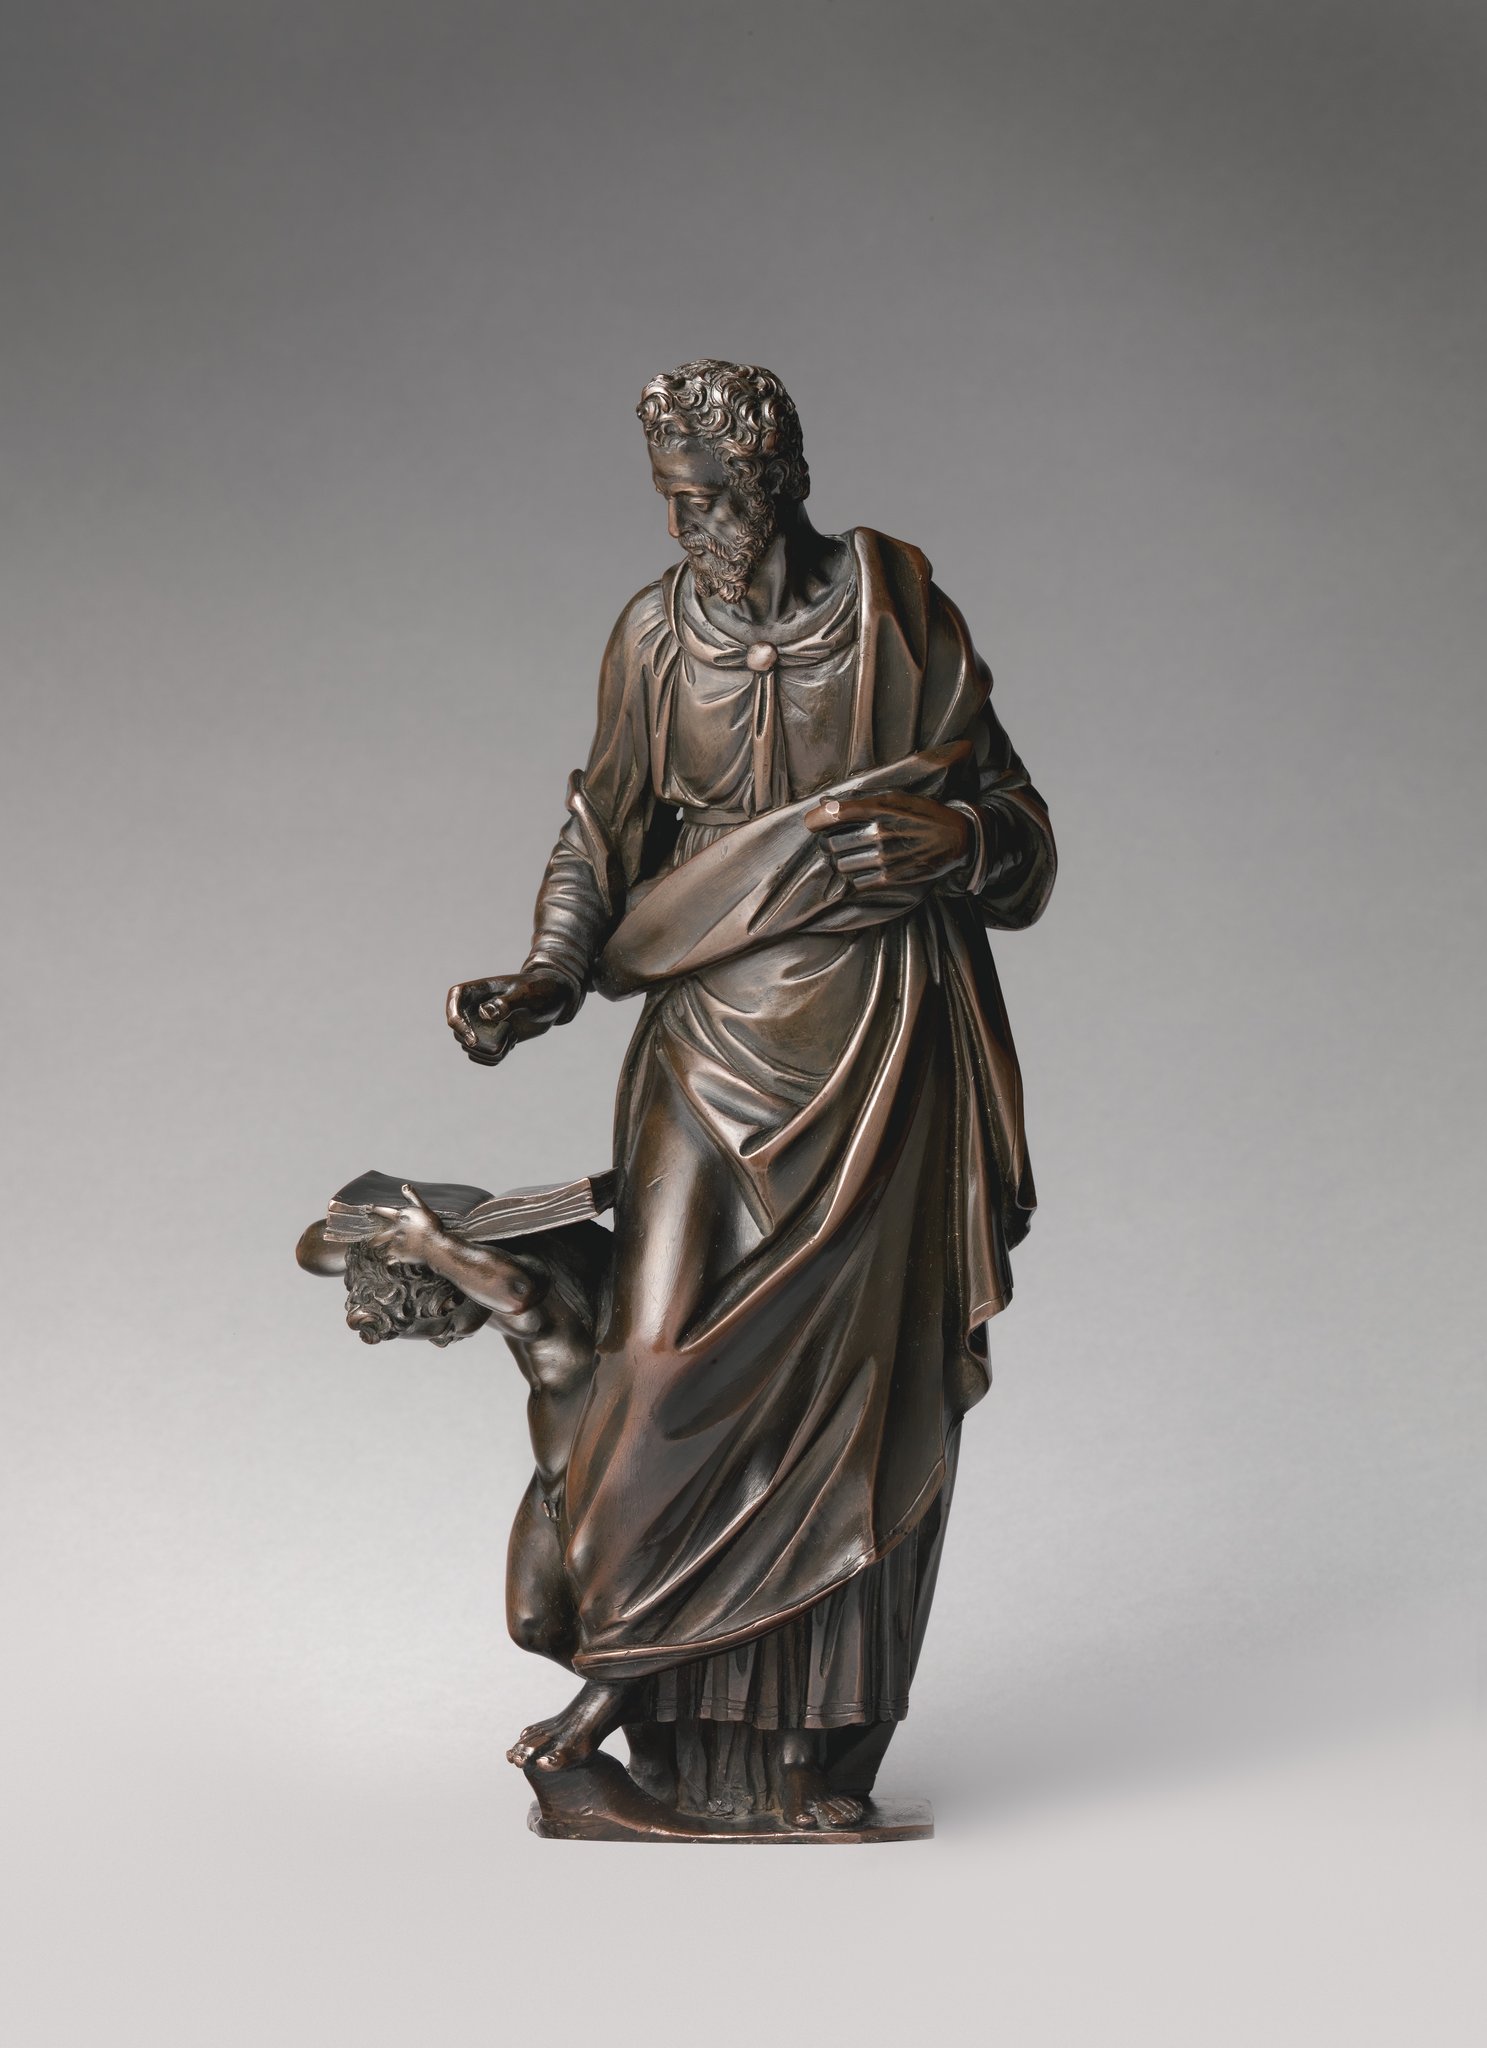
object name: statuette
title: Saint Matthew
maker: antonio susini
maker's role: artist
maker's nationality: italian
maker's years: 1558-1624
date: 1596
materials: bronze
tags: saint matthew